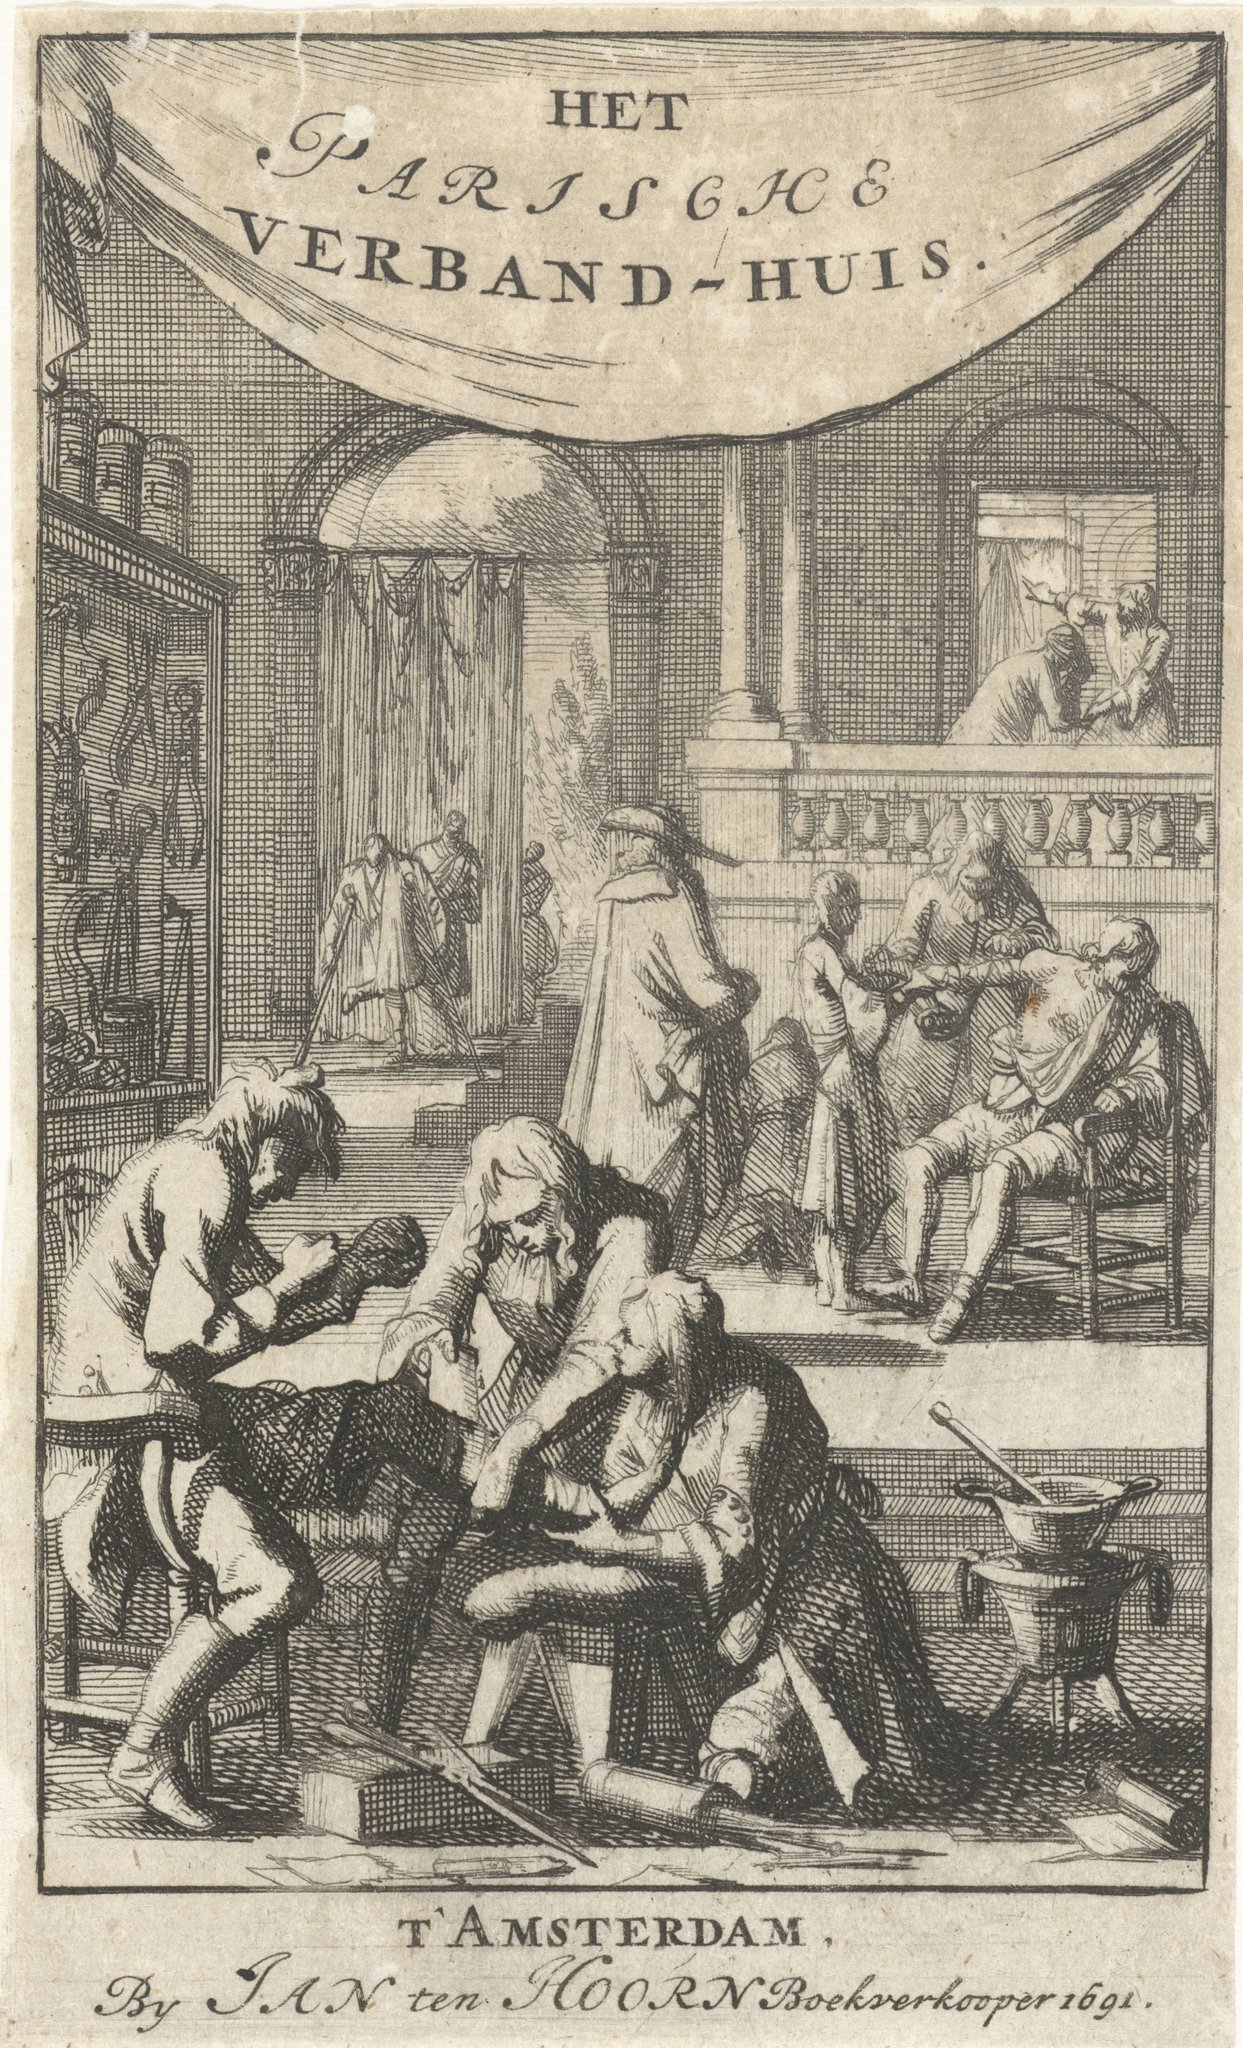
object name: titelblad, titelpagina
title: Titelpagina voor: L. Verduc, Het Parische verband-huis, 1691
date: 1691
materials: paper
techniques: etching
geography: amsterdam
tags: applying dressing or bandage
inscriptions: collector's mark: Lugt 2228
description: Titelpagina voor: Verduc, Laurent. Het Parische verband-huis, waarin getoont werd, de wyse om alle fracturen en luxatien (...) te genesen. Amsterdam: Jan Claesz ten Hoorn, 1691.